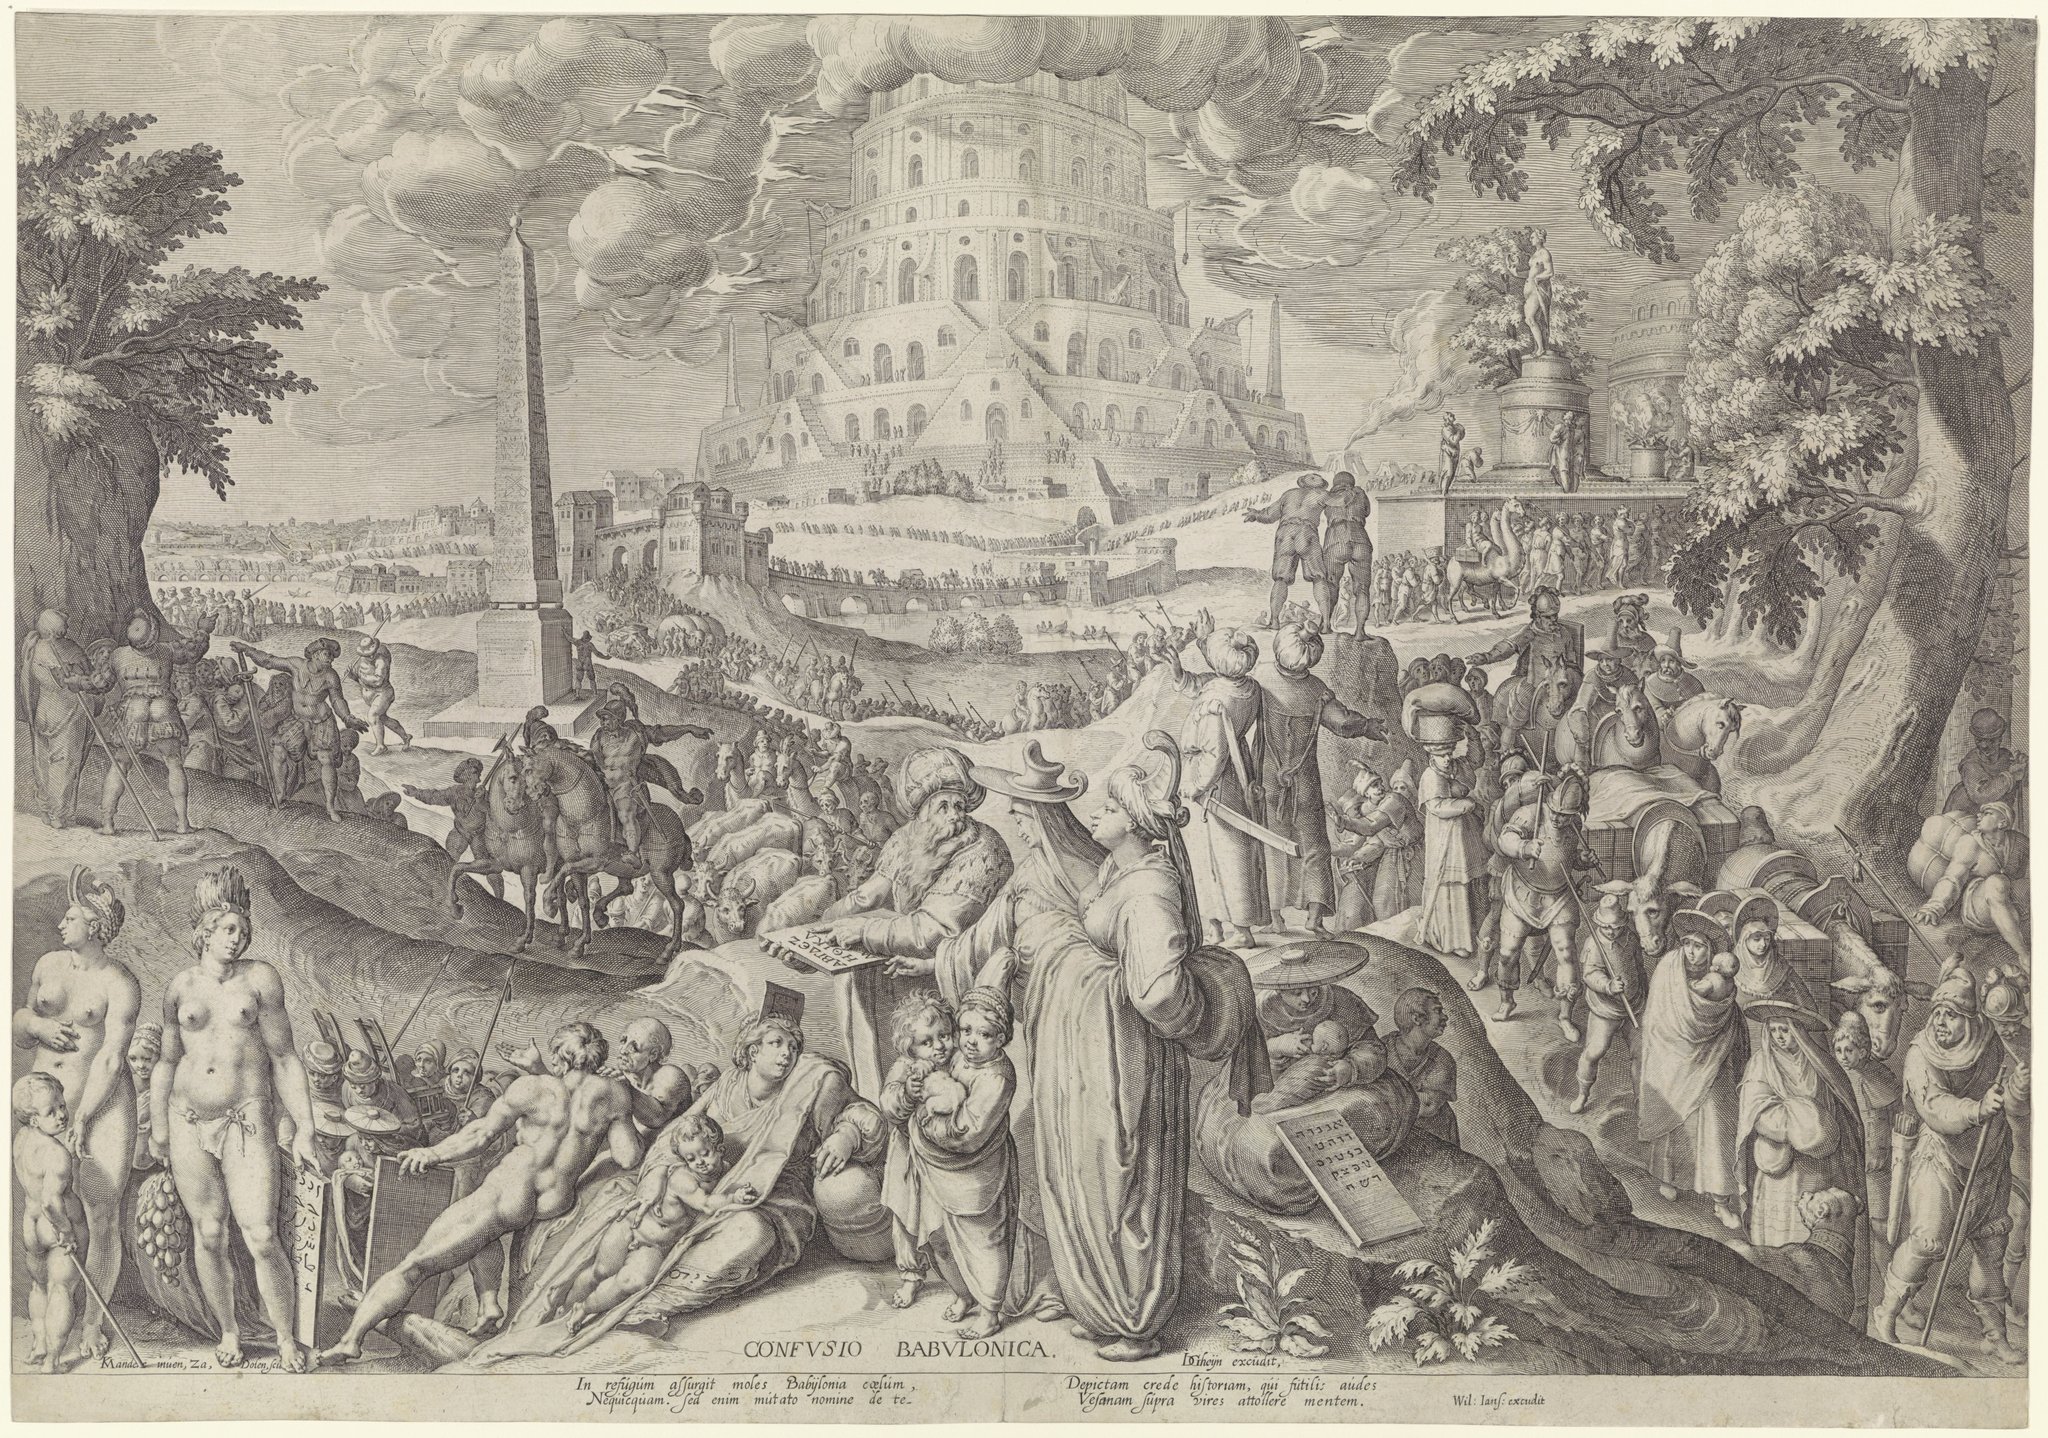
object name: print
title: Confvsio Babvlonica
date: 1597-1600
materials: paper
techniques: engraving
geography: leiden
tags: the building of the tower of babel; nimrod may be present, supervising or assisting the construction, the tower of babel, the confusion of languages and the scattering of people over the earth ~ story of the tower of babel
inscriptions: collector's mark: Lugt 2228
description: Op de achtergrond de bouw van de toren van Babel. Rondom de toren wolken en bliksem, symbool voor de woede van God. Op de voorgrond allerlei soorten mensen van verschillende rassen. Ze proberen aan de toren te werken, maar kunnen elkaars taal niet verstaan. Sommigen hebben tabletten met verschillende soorten schriften vast. Rechts vluchten al mensen uit Babylon.